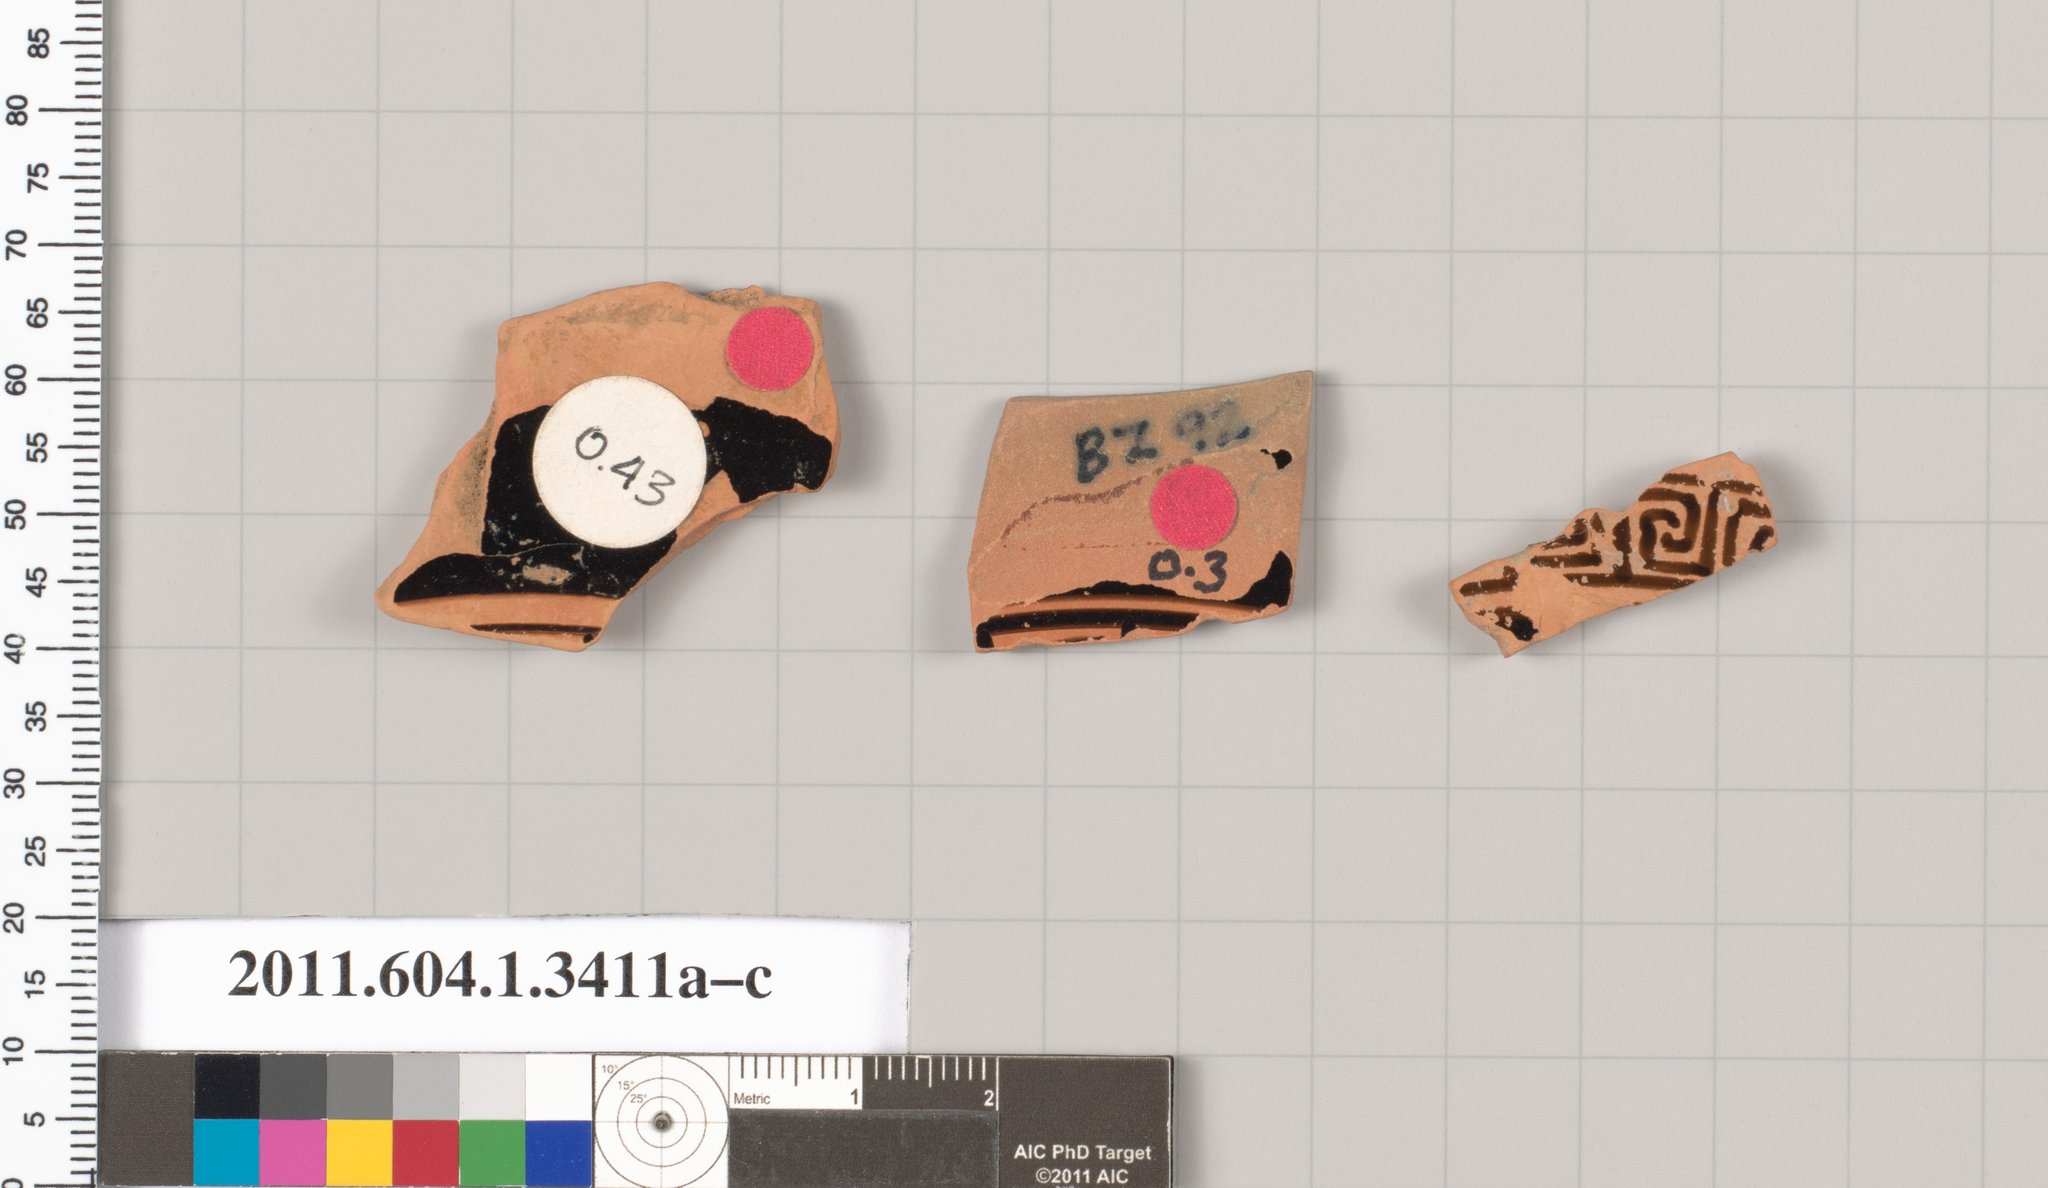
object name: kylix fragment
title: Terracotta fragments of kylikes (drinking cups)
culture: greek, attic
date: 510-470 BCE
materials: terracotta